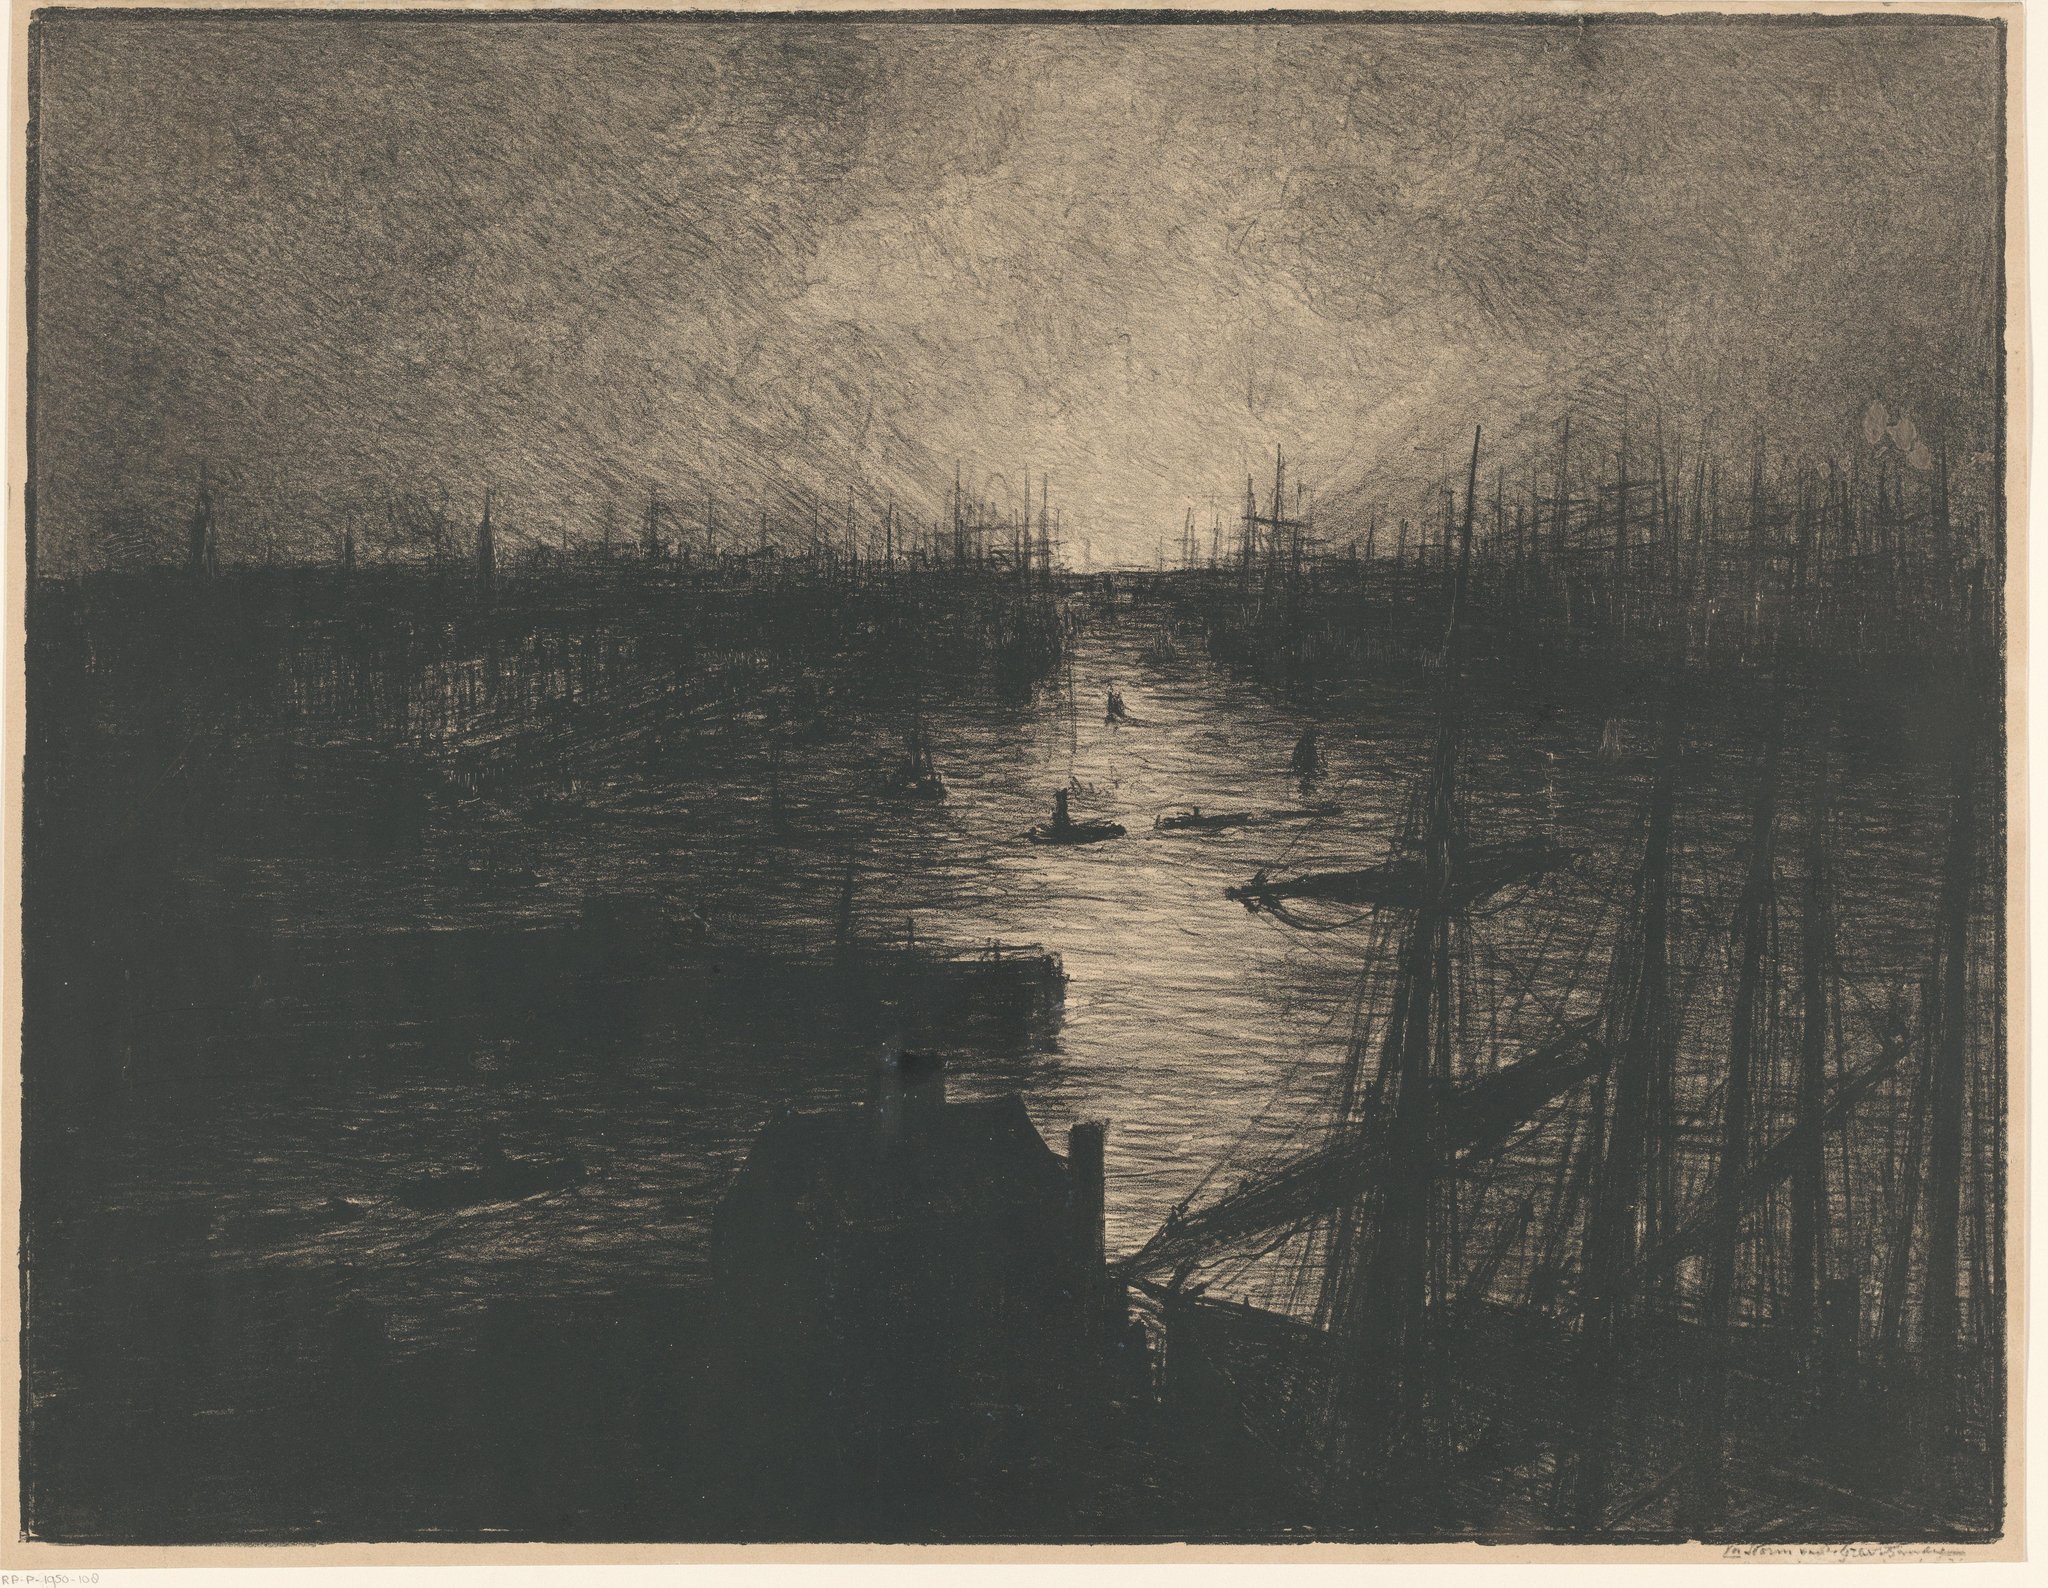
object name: print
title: Haven van Hamburg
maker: carel nicolaas storm van s-gravesande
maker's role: draughtsman, print maker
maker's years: 1841-1924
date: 1851-1924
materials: paper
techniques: lithograph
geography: netherlands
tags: harbour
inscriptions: collector's mark: Lugt 2228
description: Zeilboten en -schepen in de haven van Hamburg.